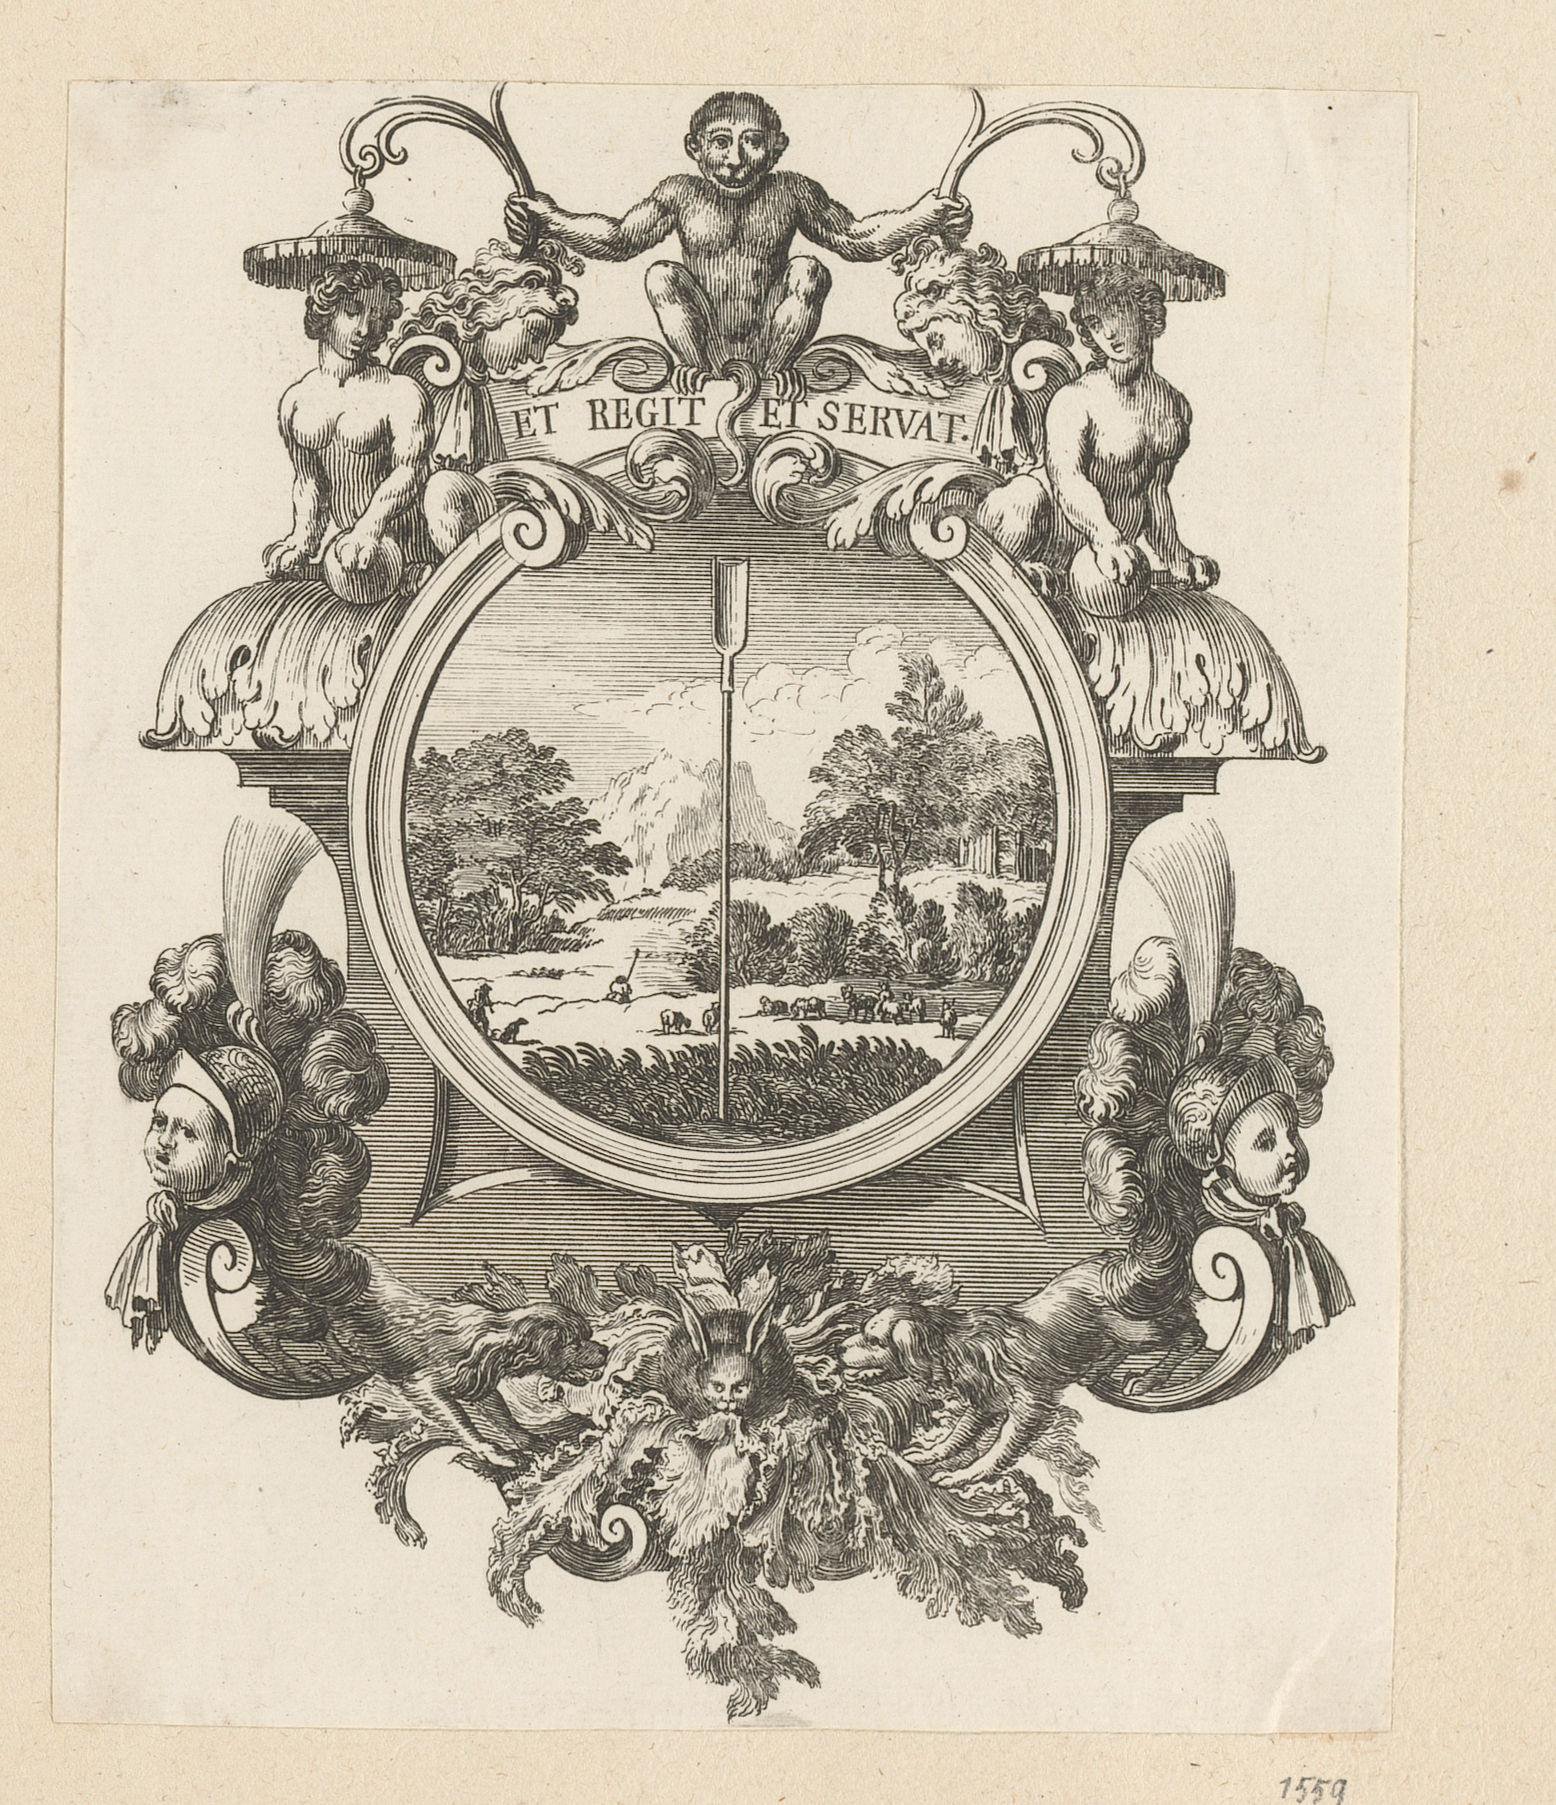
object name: album leaf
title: Et regit et servat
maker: sébastien leclerc (i)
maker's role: print maker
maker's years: 1637-1714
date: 1670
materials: paper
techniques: etching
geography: paris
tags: monkeys, apes, pastorals, arcadian scenes, shepherd's crook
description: Prent gebruikt voor: Félibien, André. Devises pour les tapisseries du Roy, où sont représentez les quatre éléments et les quatre saisons de l'année (...). Parijs: Imprimerie Royale, 1670.